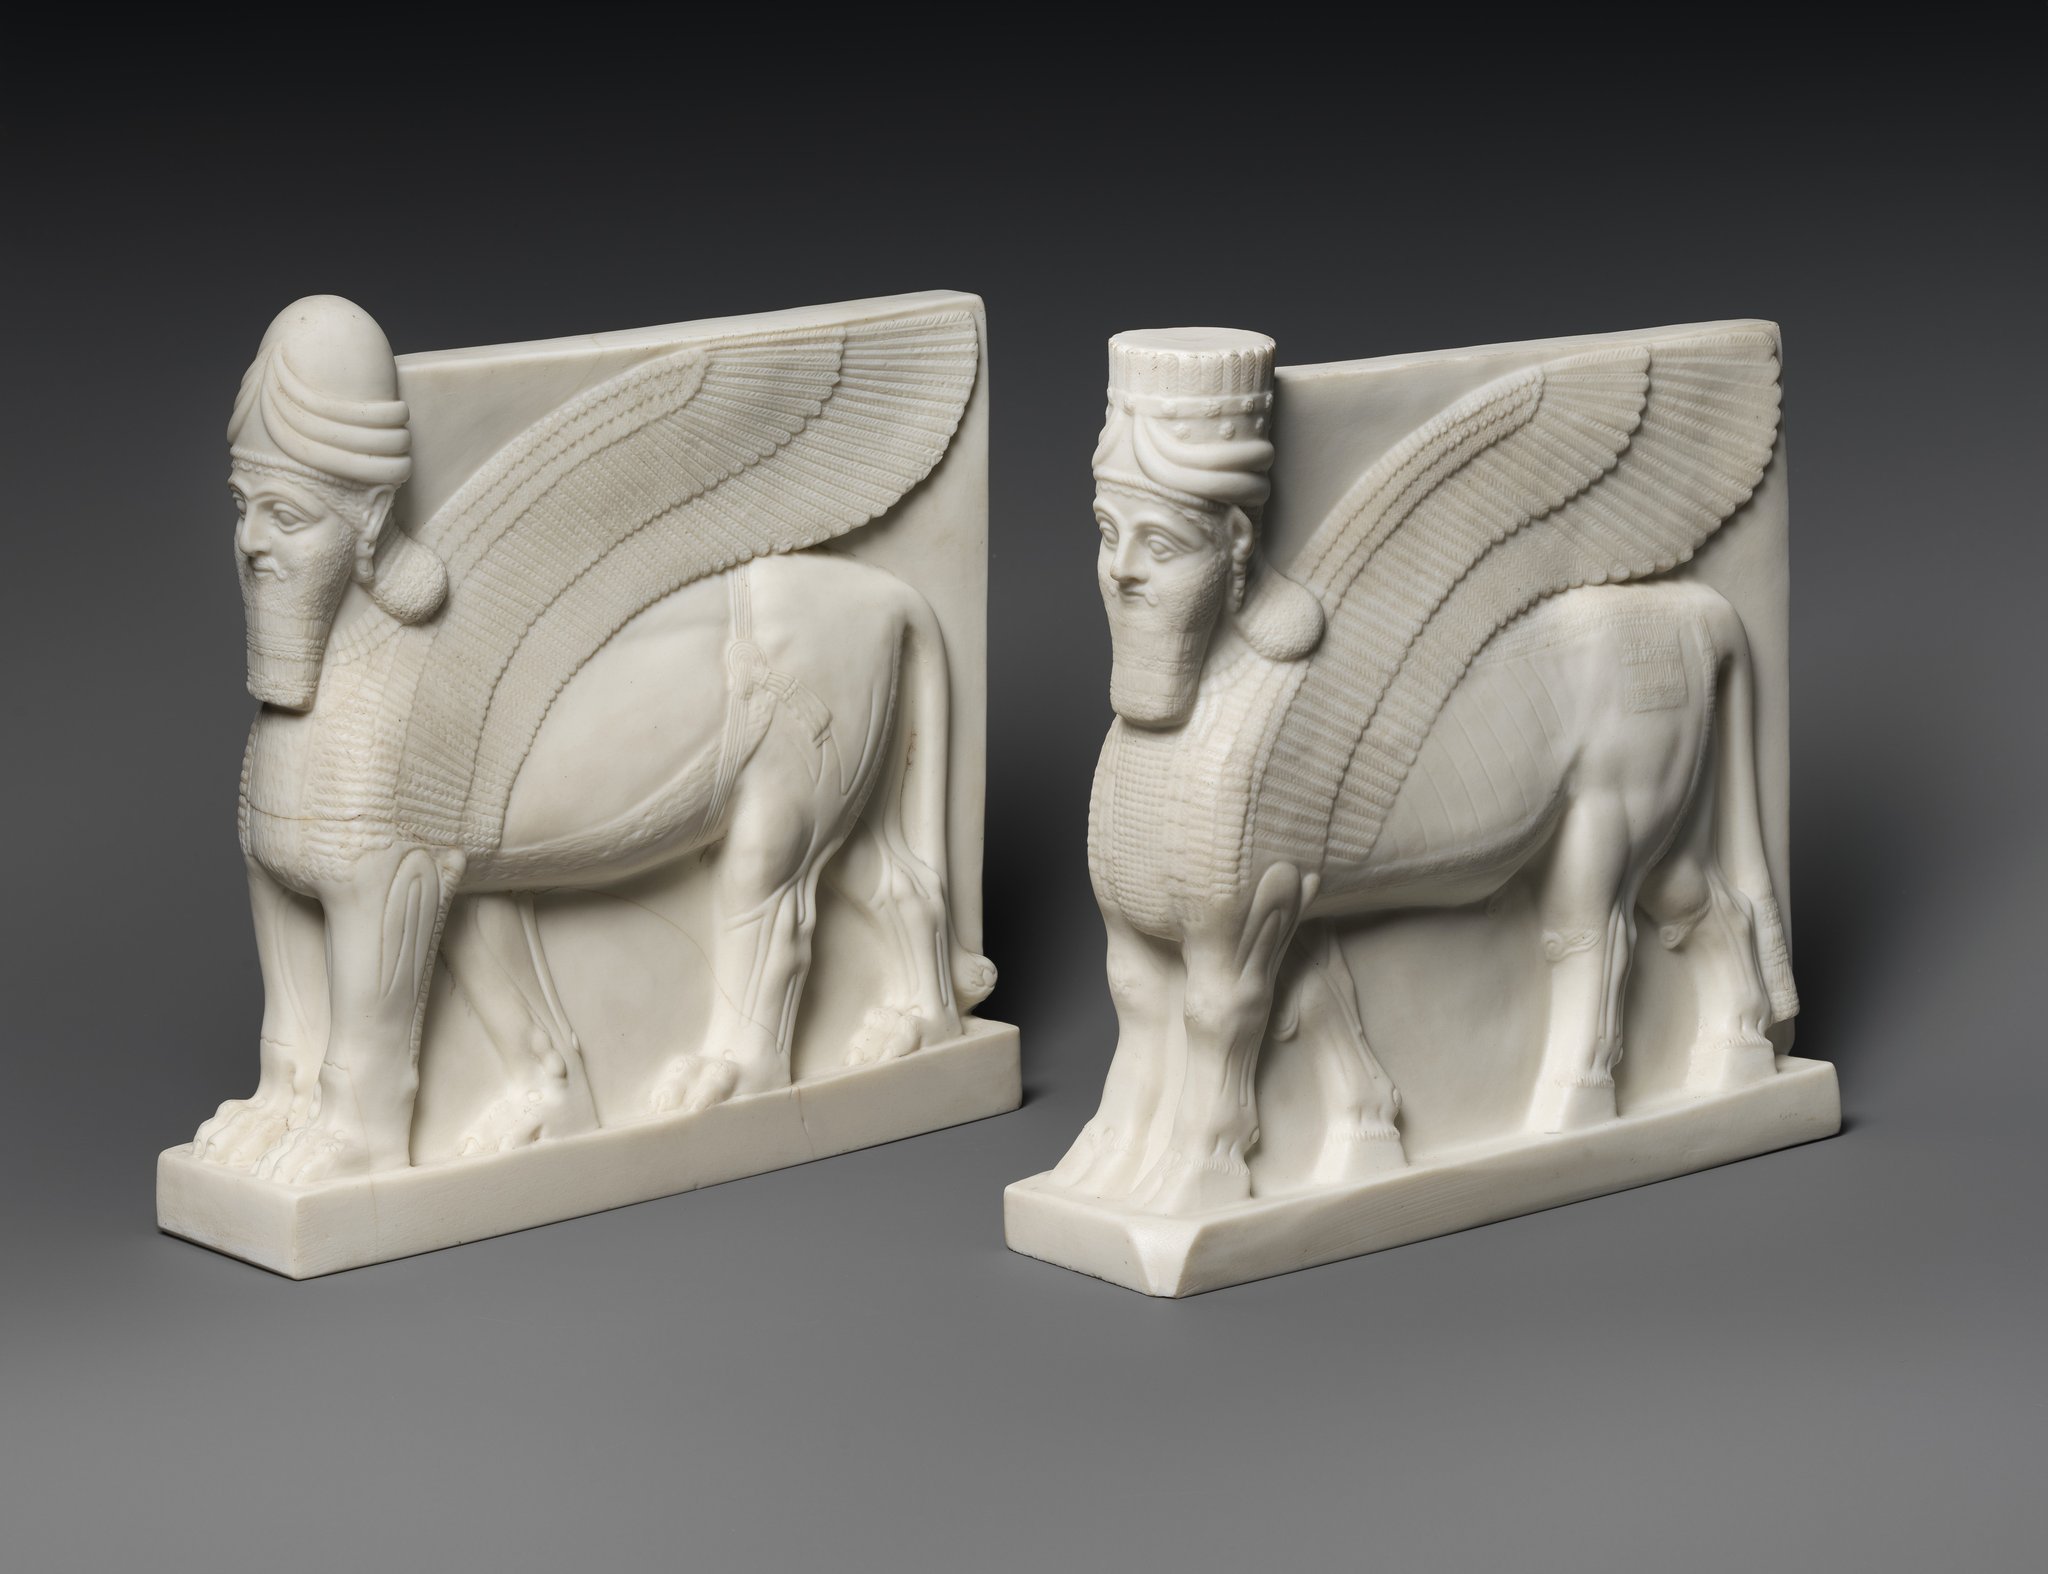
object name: bookend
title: Human-headed winged lion and bull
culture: british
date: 1893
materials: porcelain